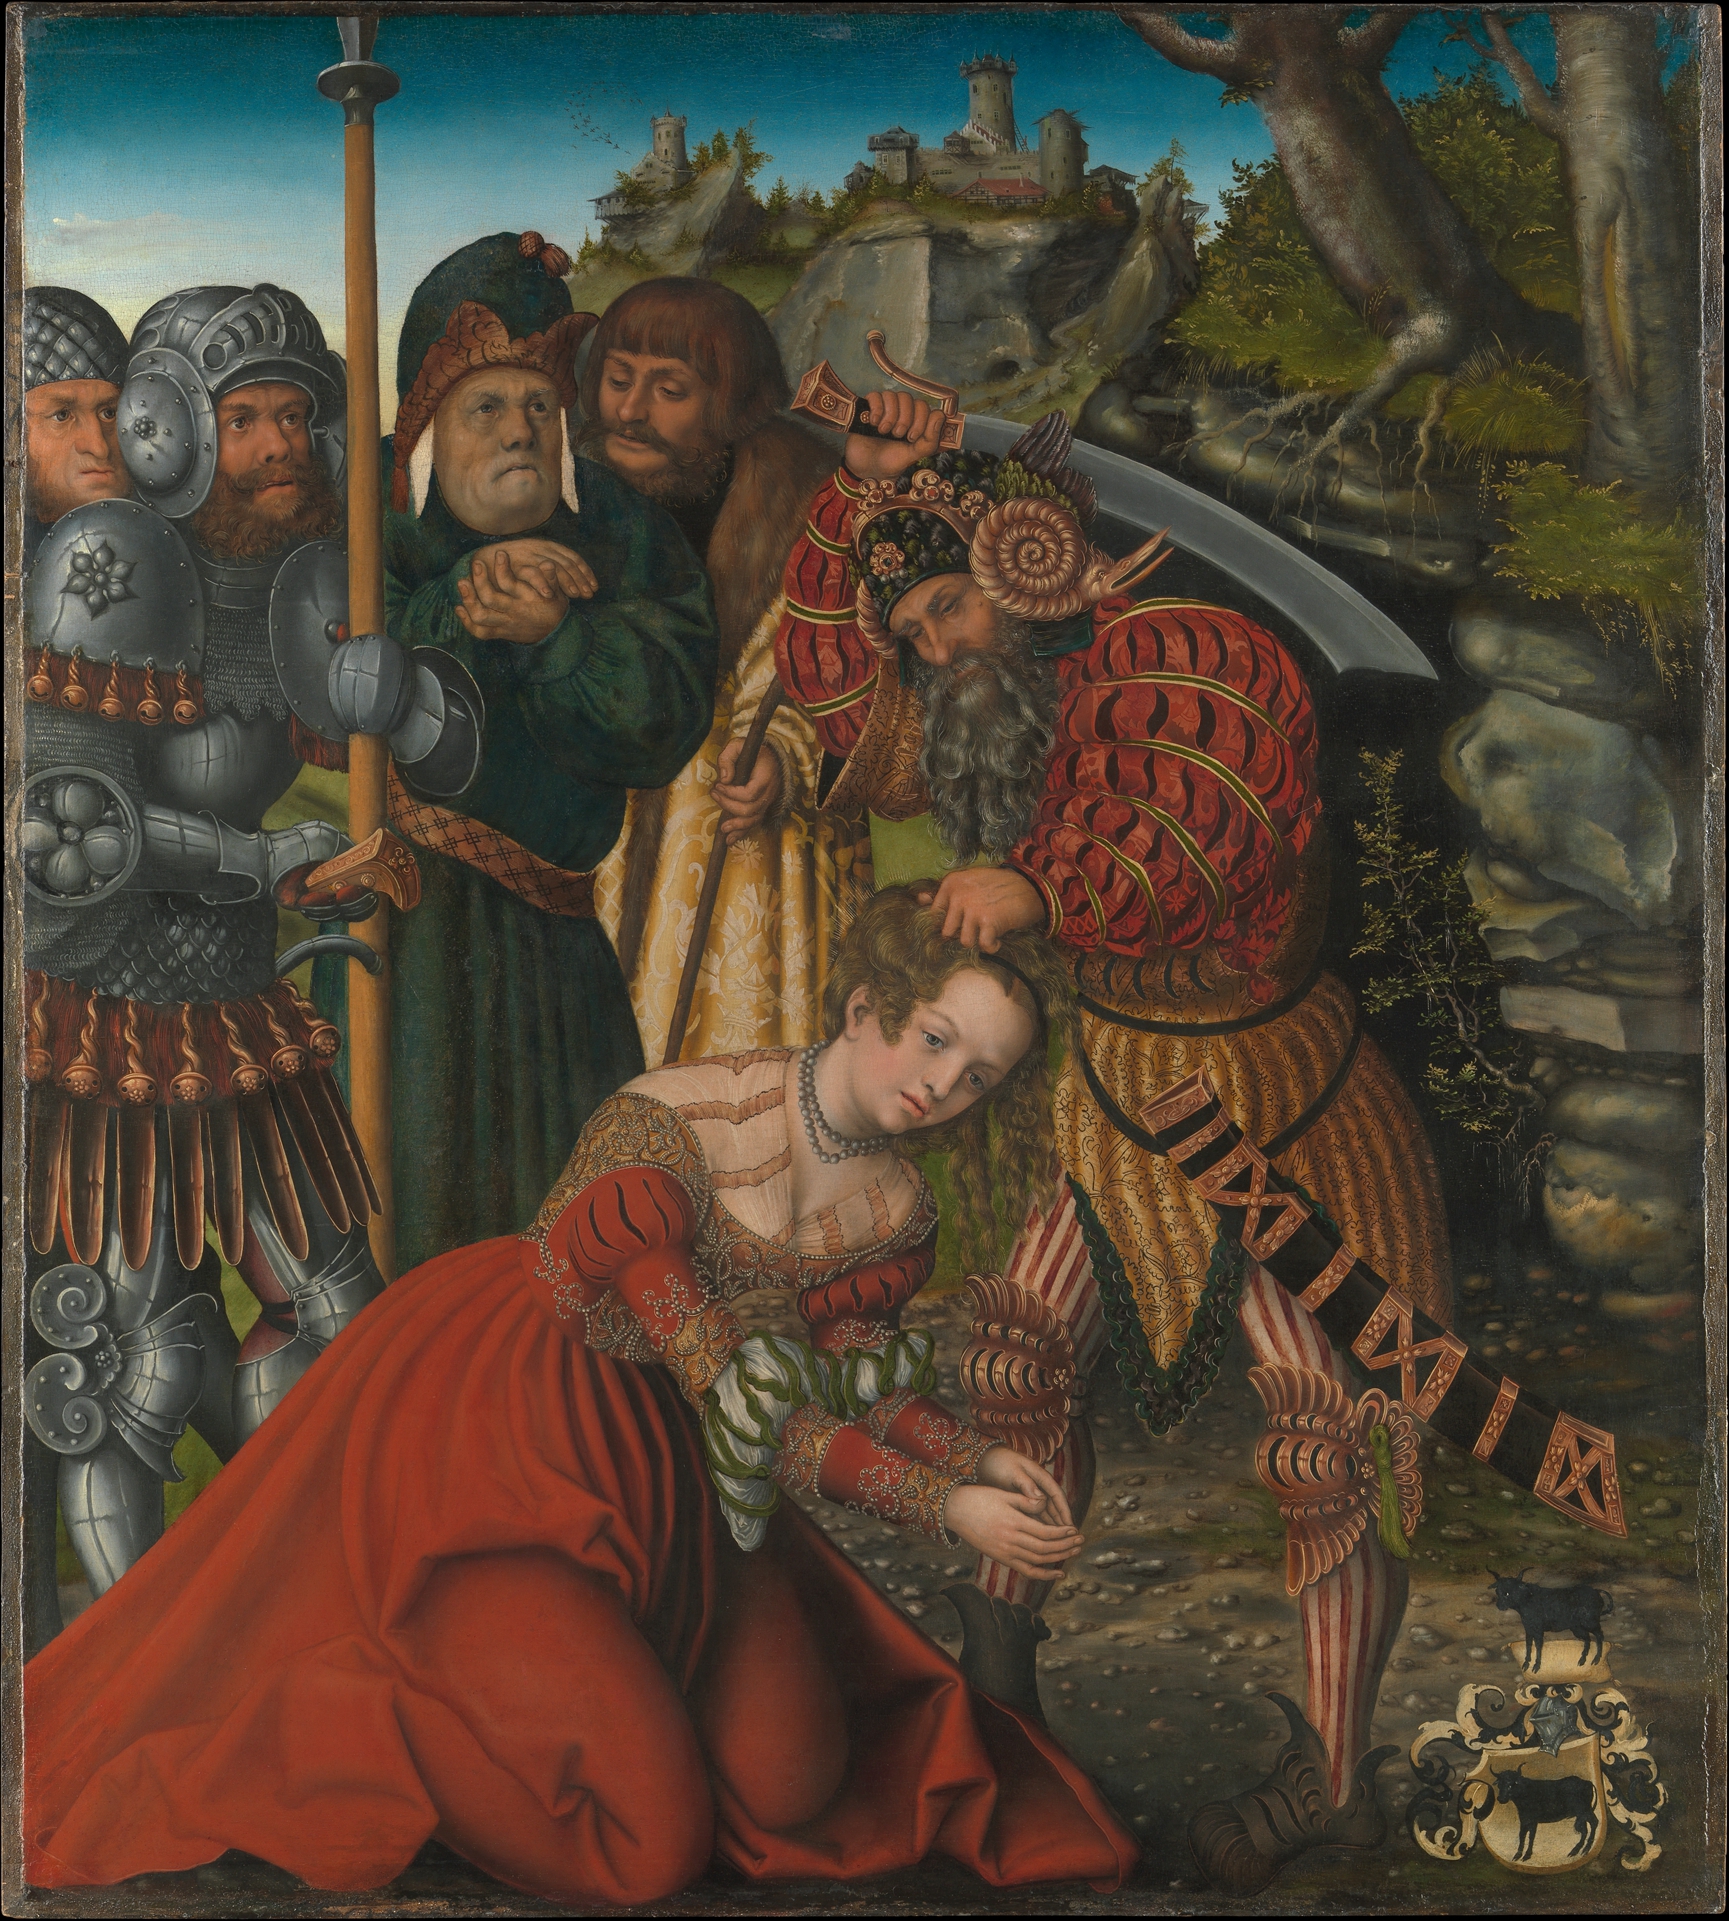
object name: painting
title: The Martyrdom of Saint Barbara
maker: lucas cranach the elder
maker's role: artist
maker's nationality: german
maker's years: 1472-1553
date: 1510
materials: wood, oil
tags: soldiers,armor,swords,men,saints,coat of arms